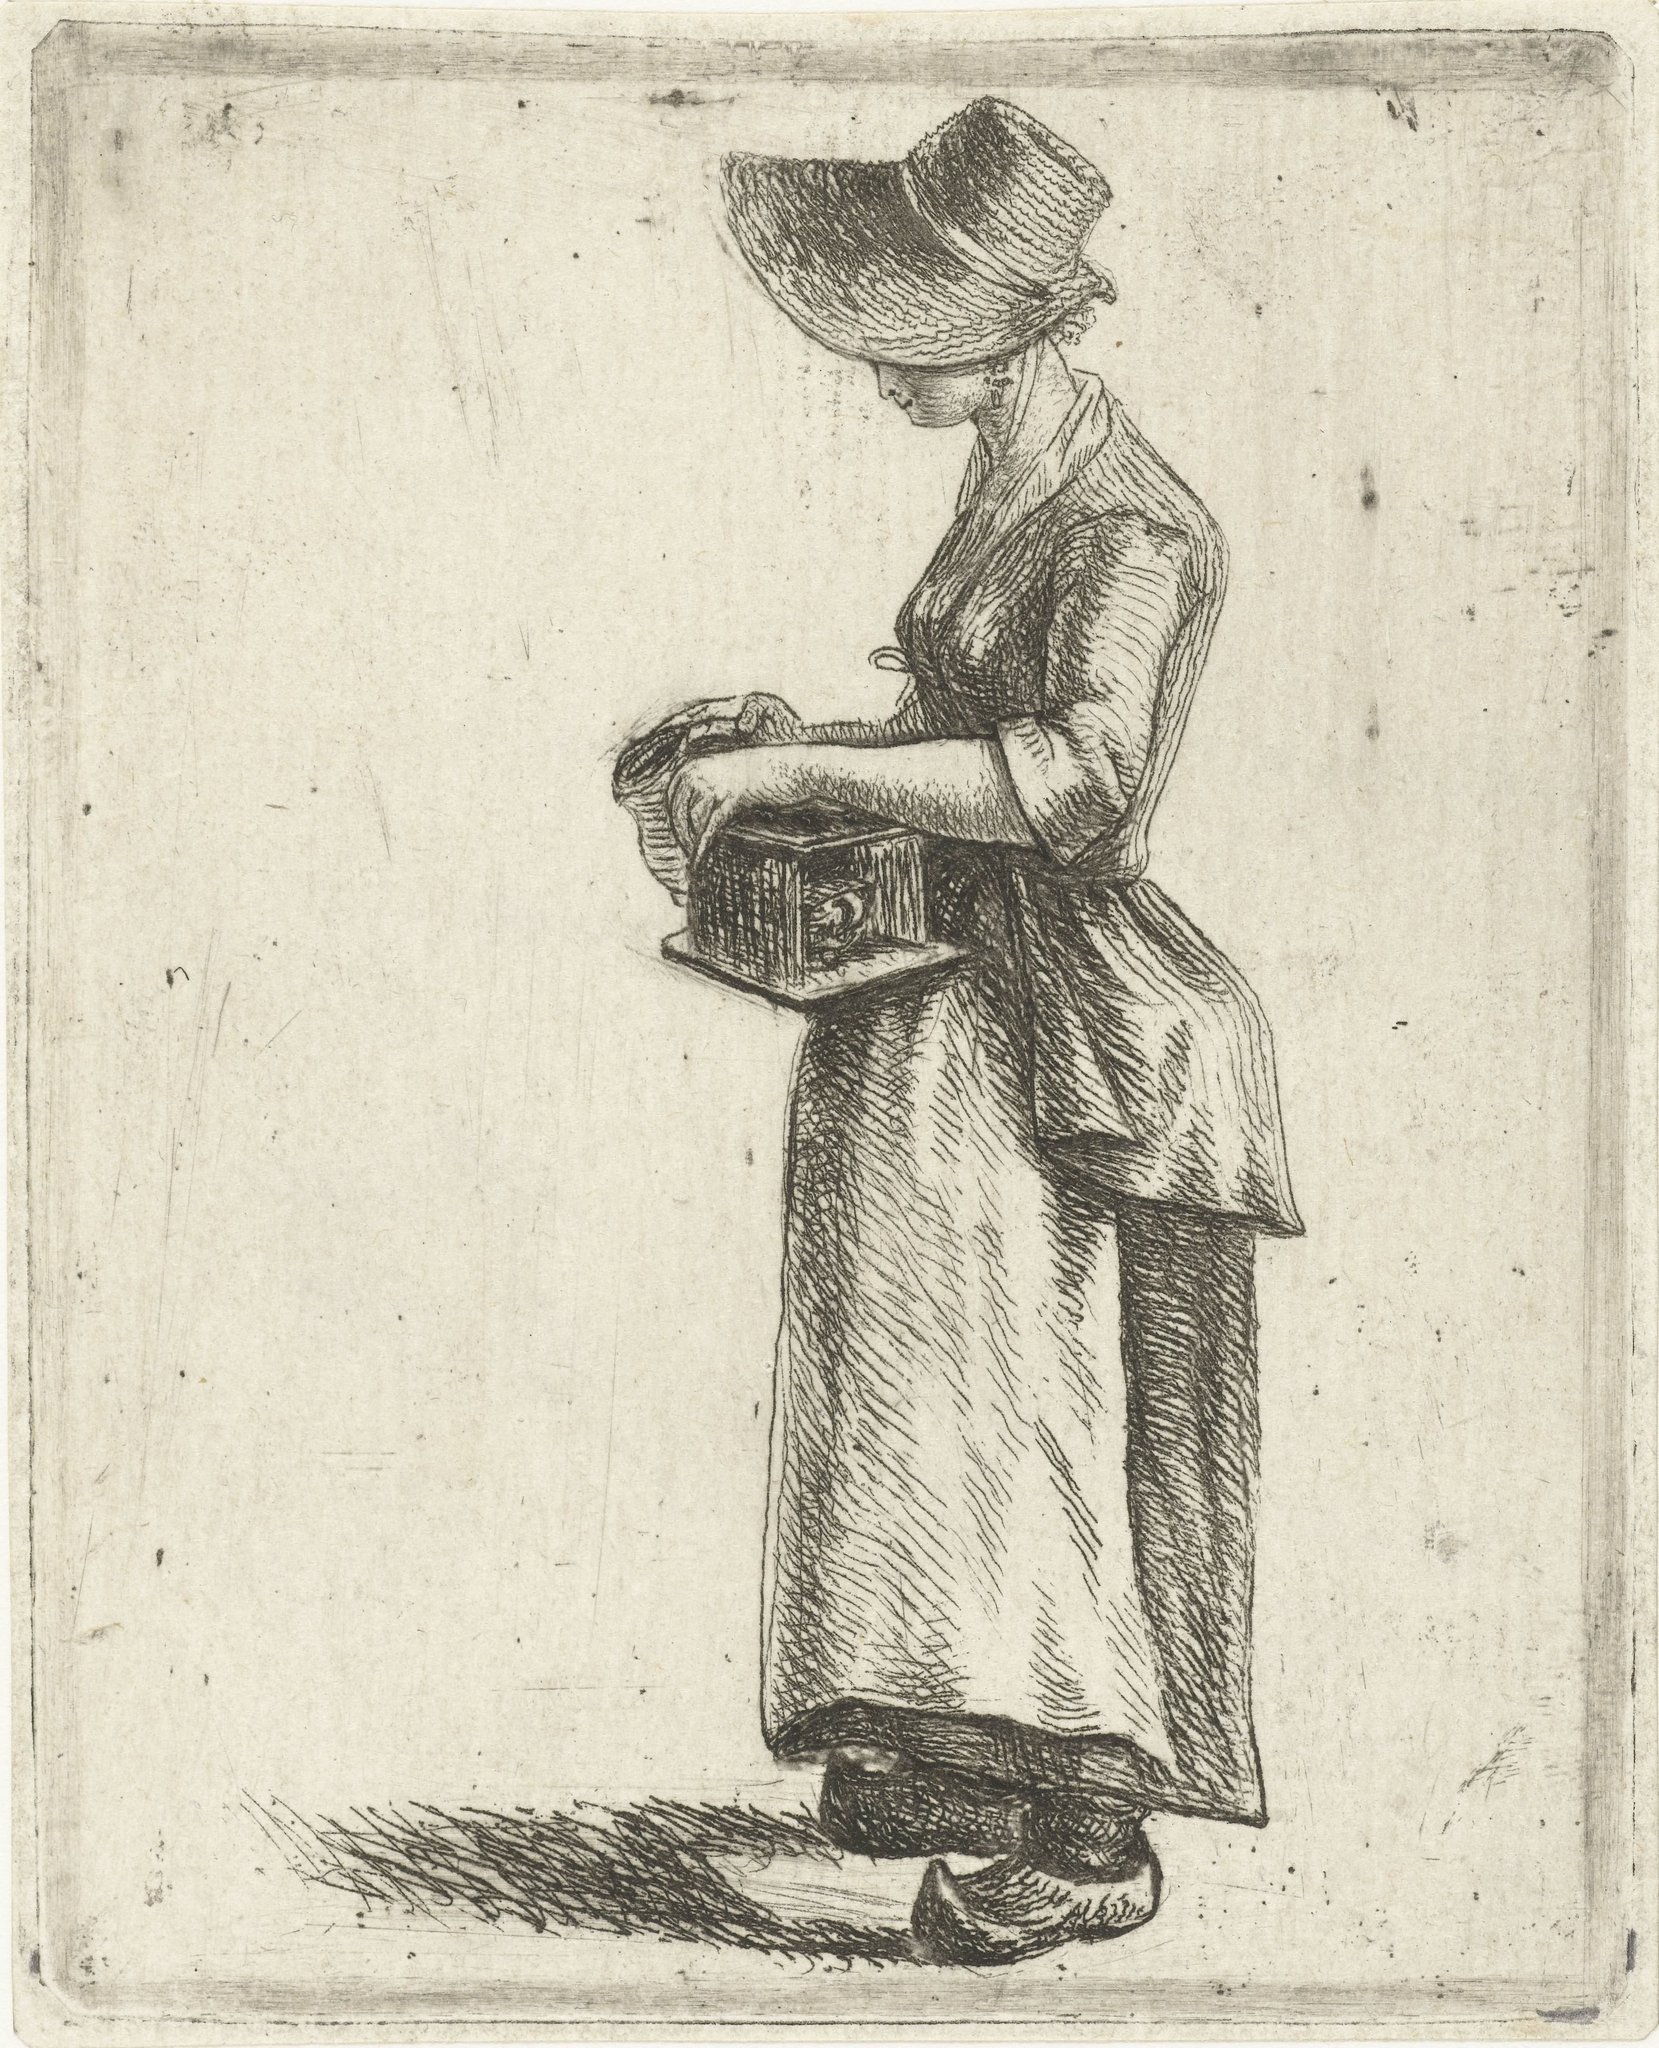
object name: print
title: Dienstmeid met stoof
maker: marie lambertine coclers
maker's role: conservator, draughtsman, print maker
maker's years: 1761-1815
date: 1776-1815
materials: paper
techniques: drypoint, etching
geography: amsterdam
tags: wooden shoes, clogs (+ women's clothes), head-gear (straw hat) (+ women's clothes), warming oneself at a fire (or hearth, stove, fire-pan, brazier), apron (+ women's clothes)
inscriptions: collector's mark: Lugt 2228, collector's mark: ‘Concordia et sed ...; ADG’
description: Een jonge vrouw met strohoed, wit schort en klompen, in profiel naar links. Ze houdt met beide handen een stoof vast.